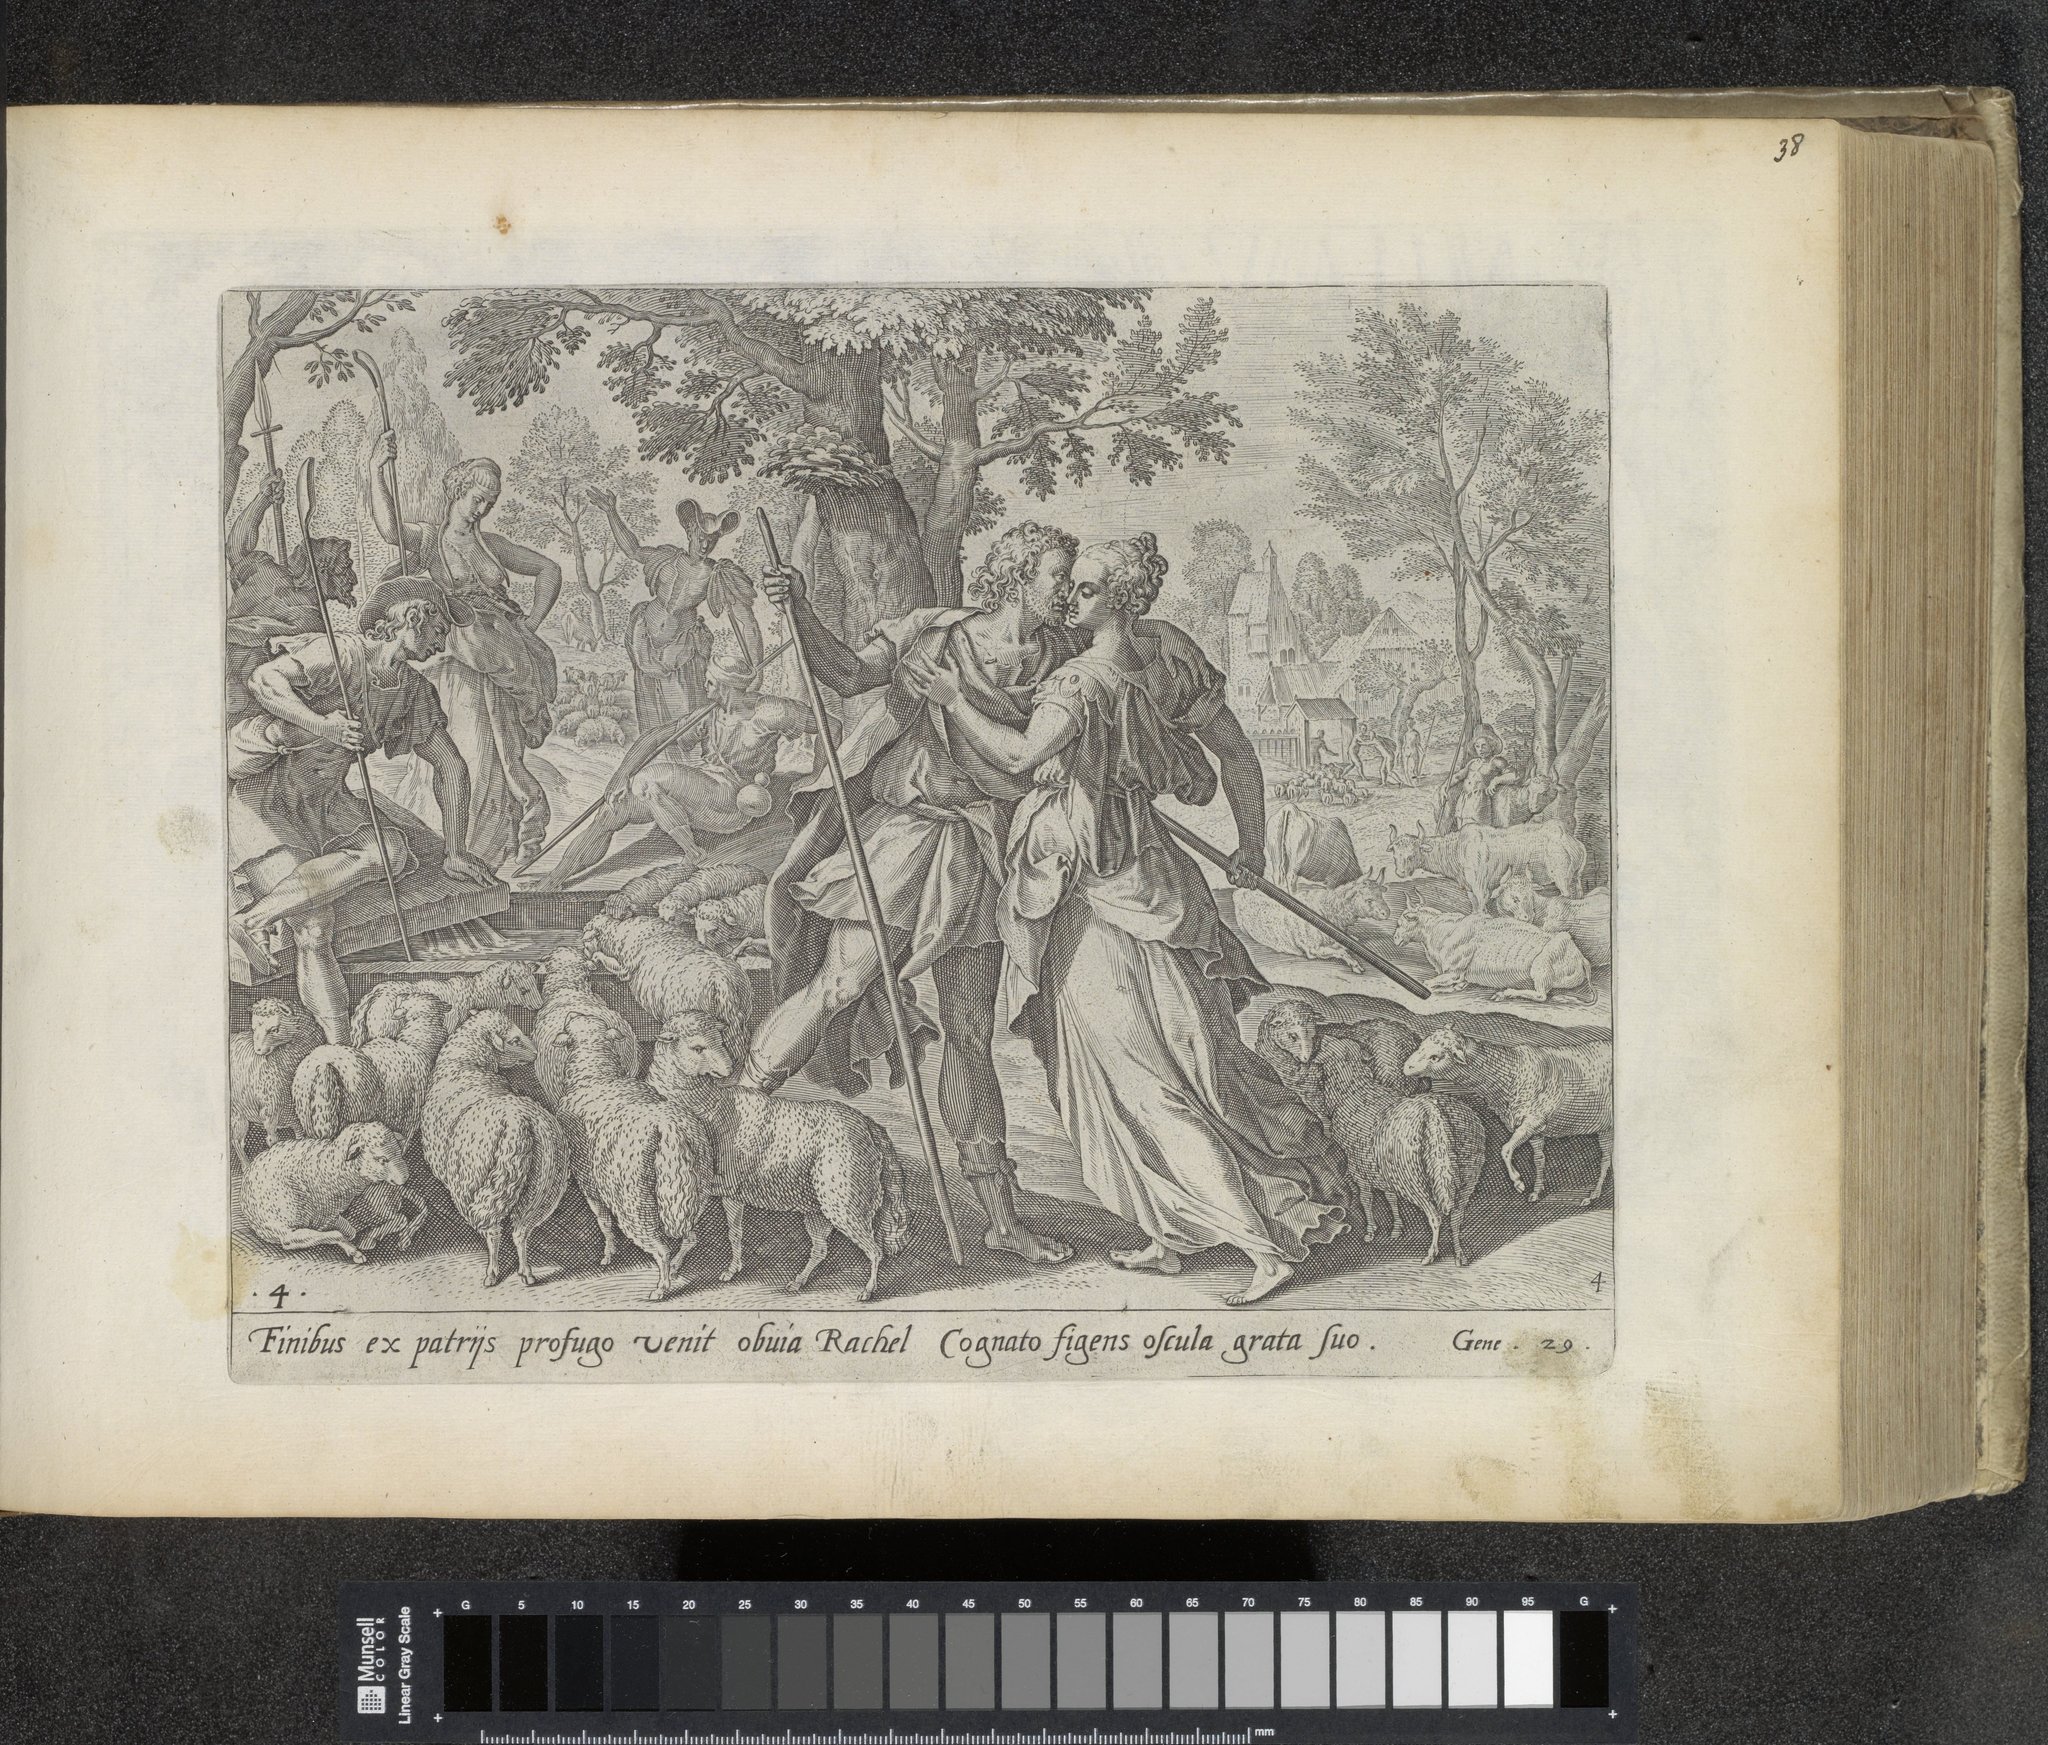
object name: album leaf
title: Geschiedenis van Jakob en Esau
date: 1579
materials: paper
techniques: engraving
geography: amsterdam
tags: jacob kisses rachel and is moved to tears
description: Bij de bron in Haran ontmoet Jakob Rachel, die haar vaders schapen te drinken geeft. Jakob omhelst Rachel. Daarnaast drinken de schapen bij de put, waarvan Jakob de deksteen heeft verwijderd. Onder de voorstelling een verwijzing in het Latijn naar de Bijbeltekst in Gen. 29. Deze prent maakt deel uit van een album.